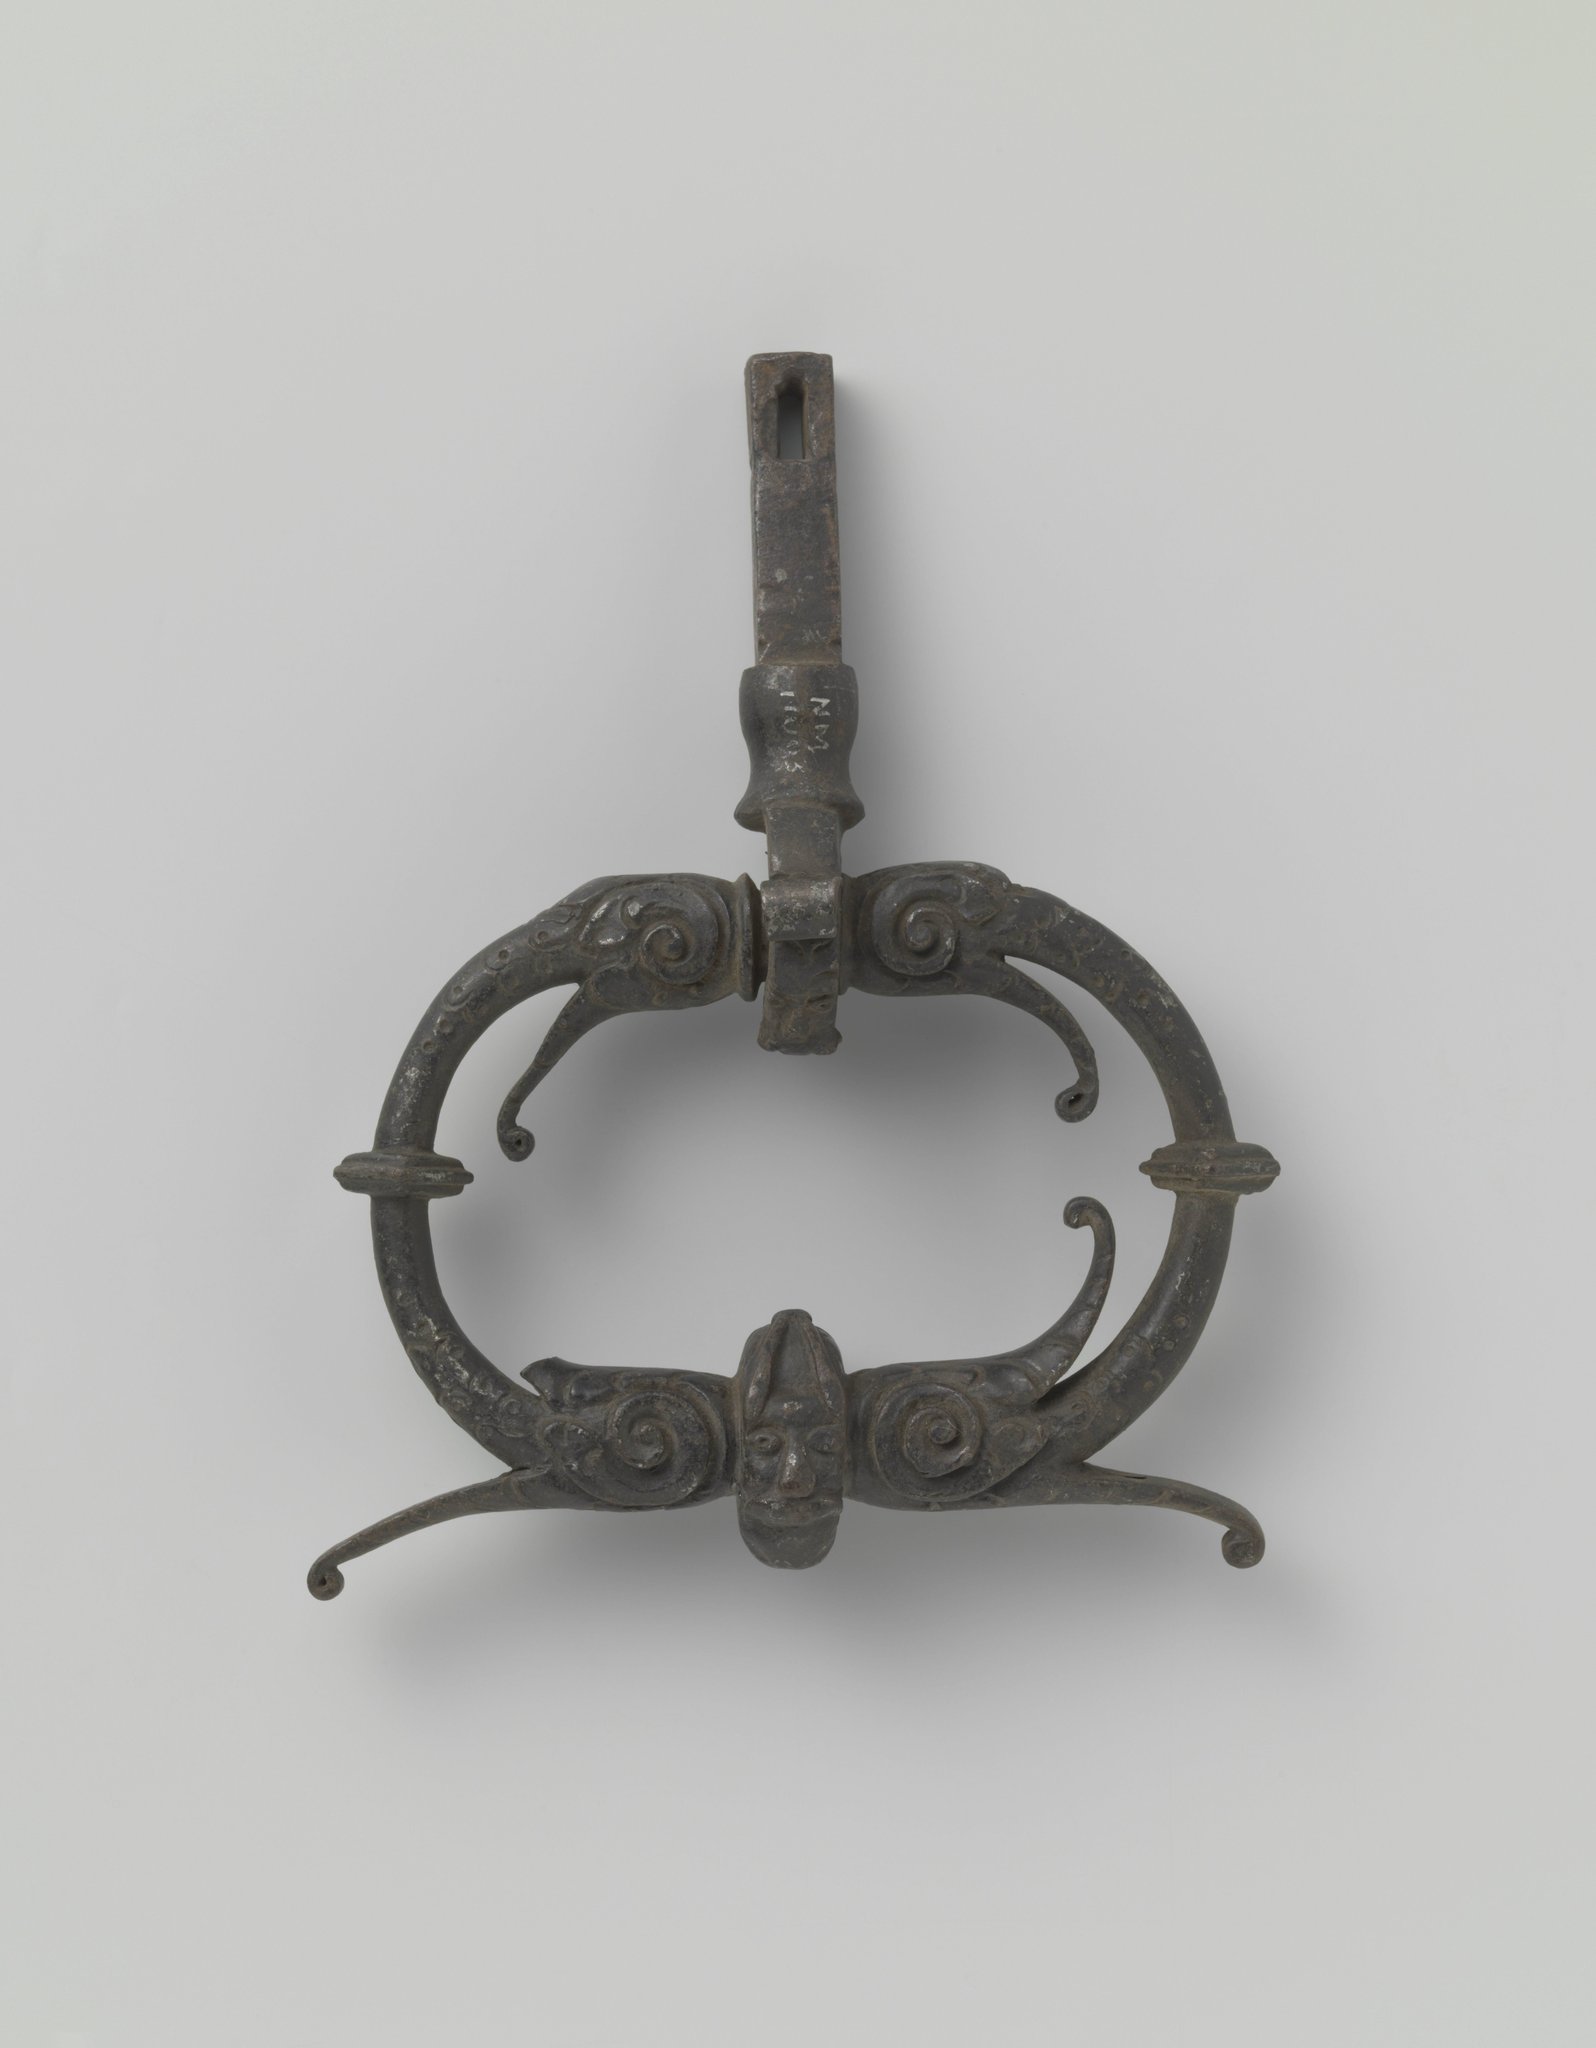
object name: door knocker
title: Deurklopper met draakornament en twee mascarons.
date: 1500-1600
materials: iron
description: Een gesmeed ijzeren deurklopper in de vorm van een ring; draakornament en twee mascarons.